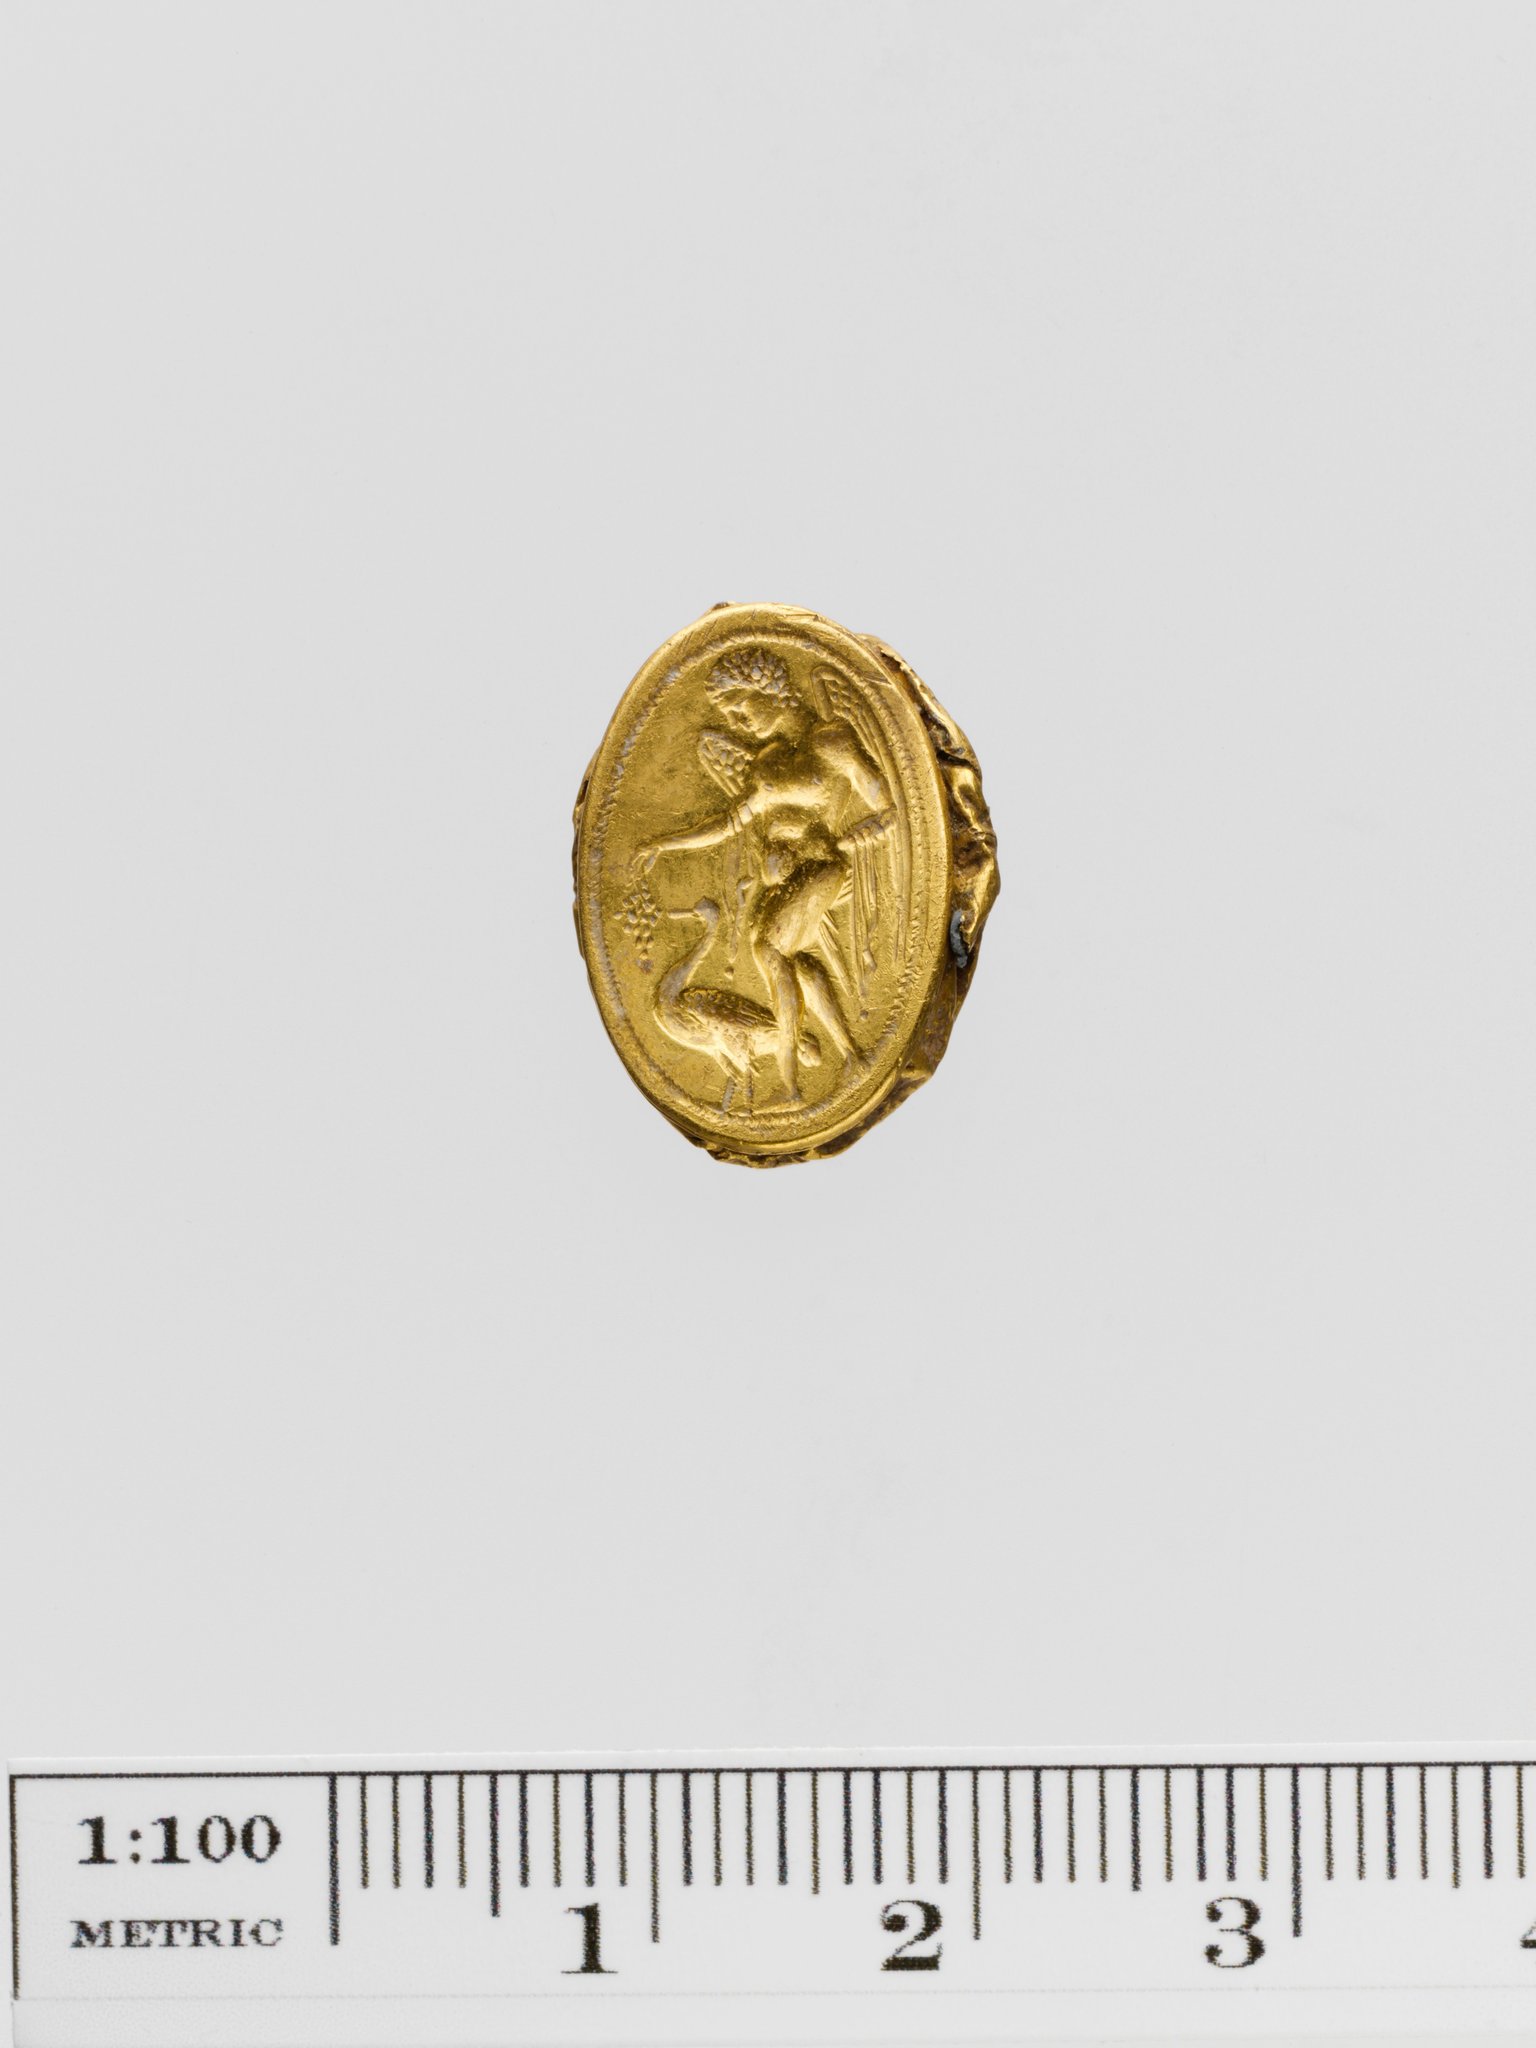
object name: scarab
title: Gold scarab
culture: greek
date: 400-301 BCE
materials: gold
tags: grapes,eros,scarabs